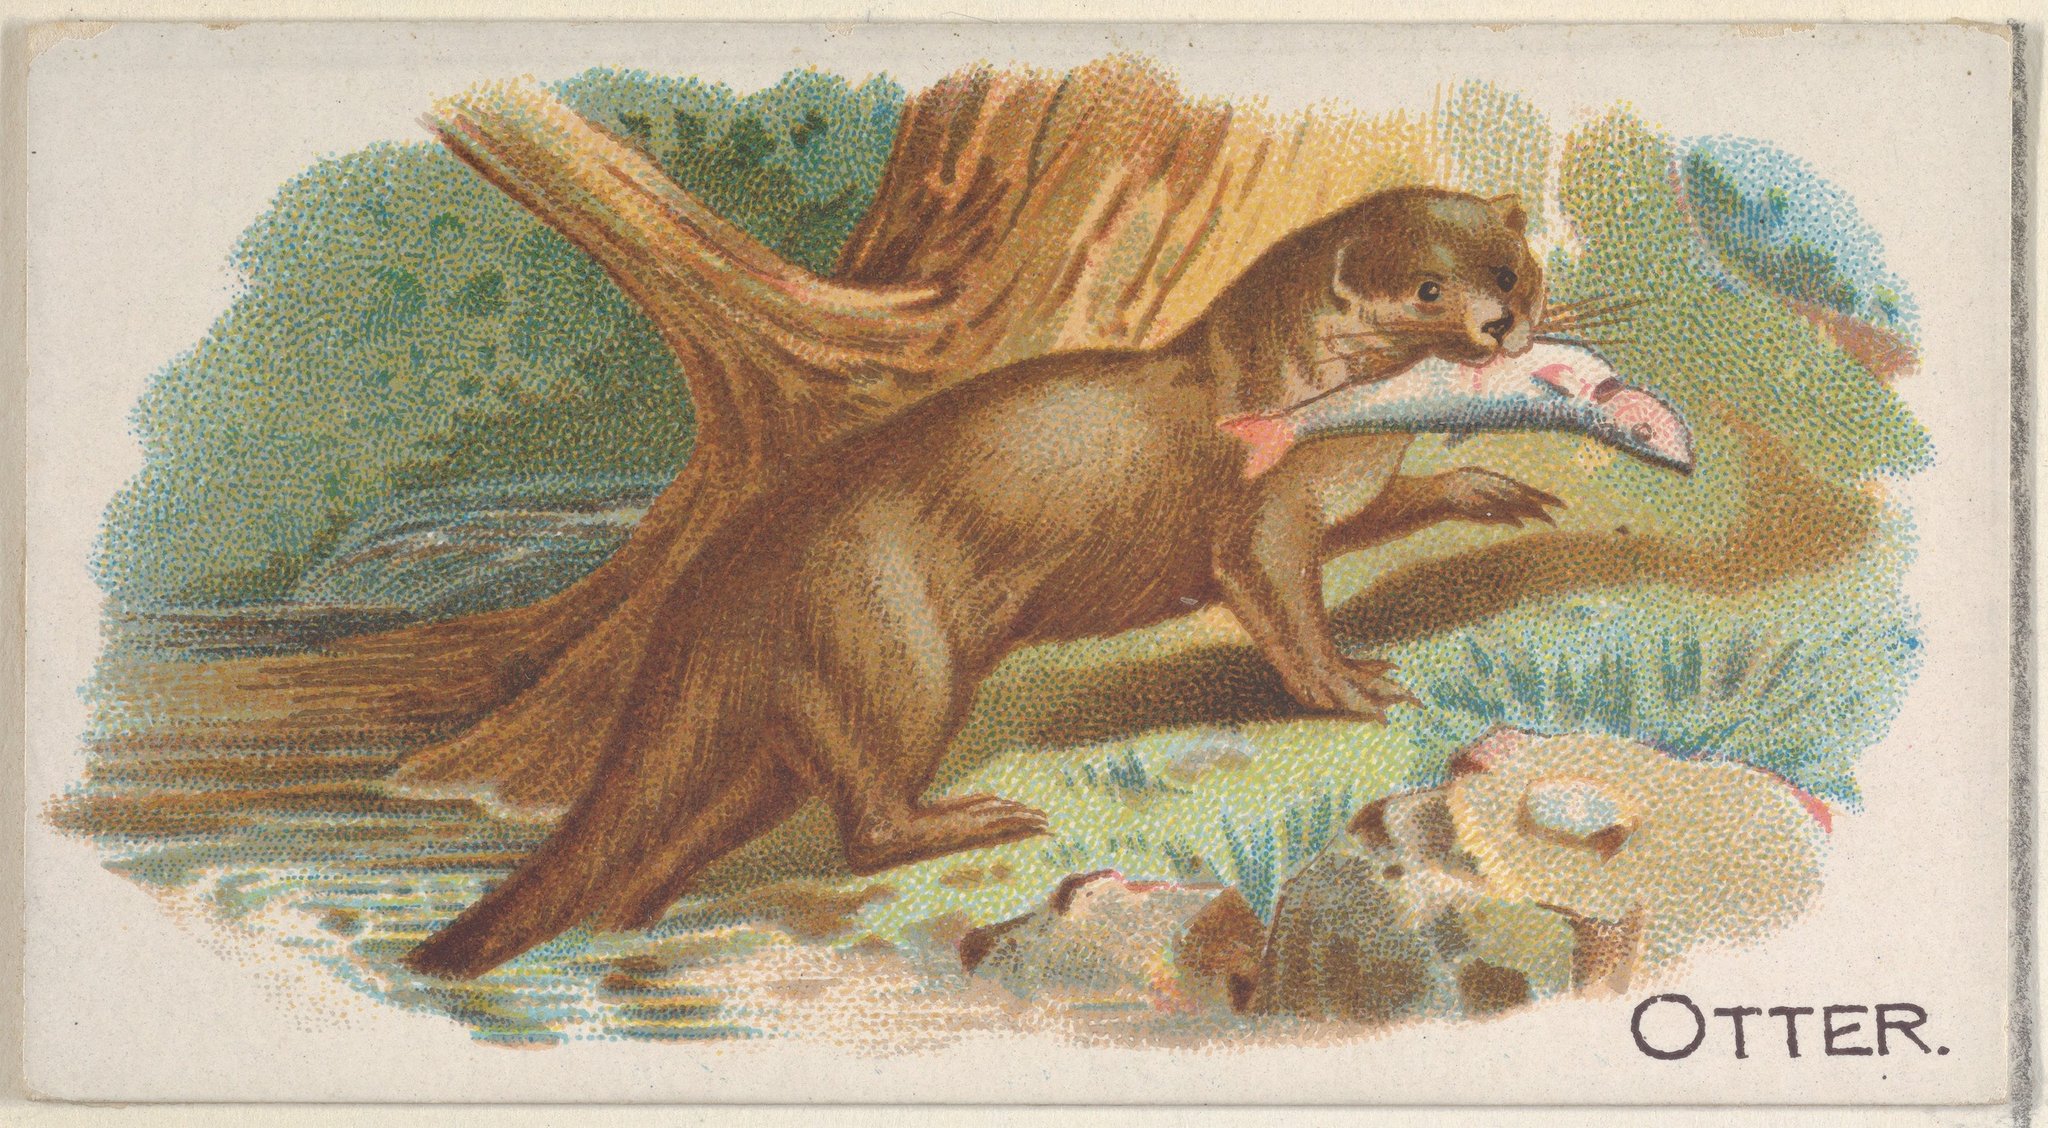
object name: print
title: Otter, from the Quadrupeds series (N21) for Allen & Ginter Cigarettes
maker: allen & ginter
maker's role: publisher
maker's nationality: american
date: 1890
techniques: color lithograph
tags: animals